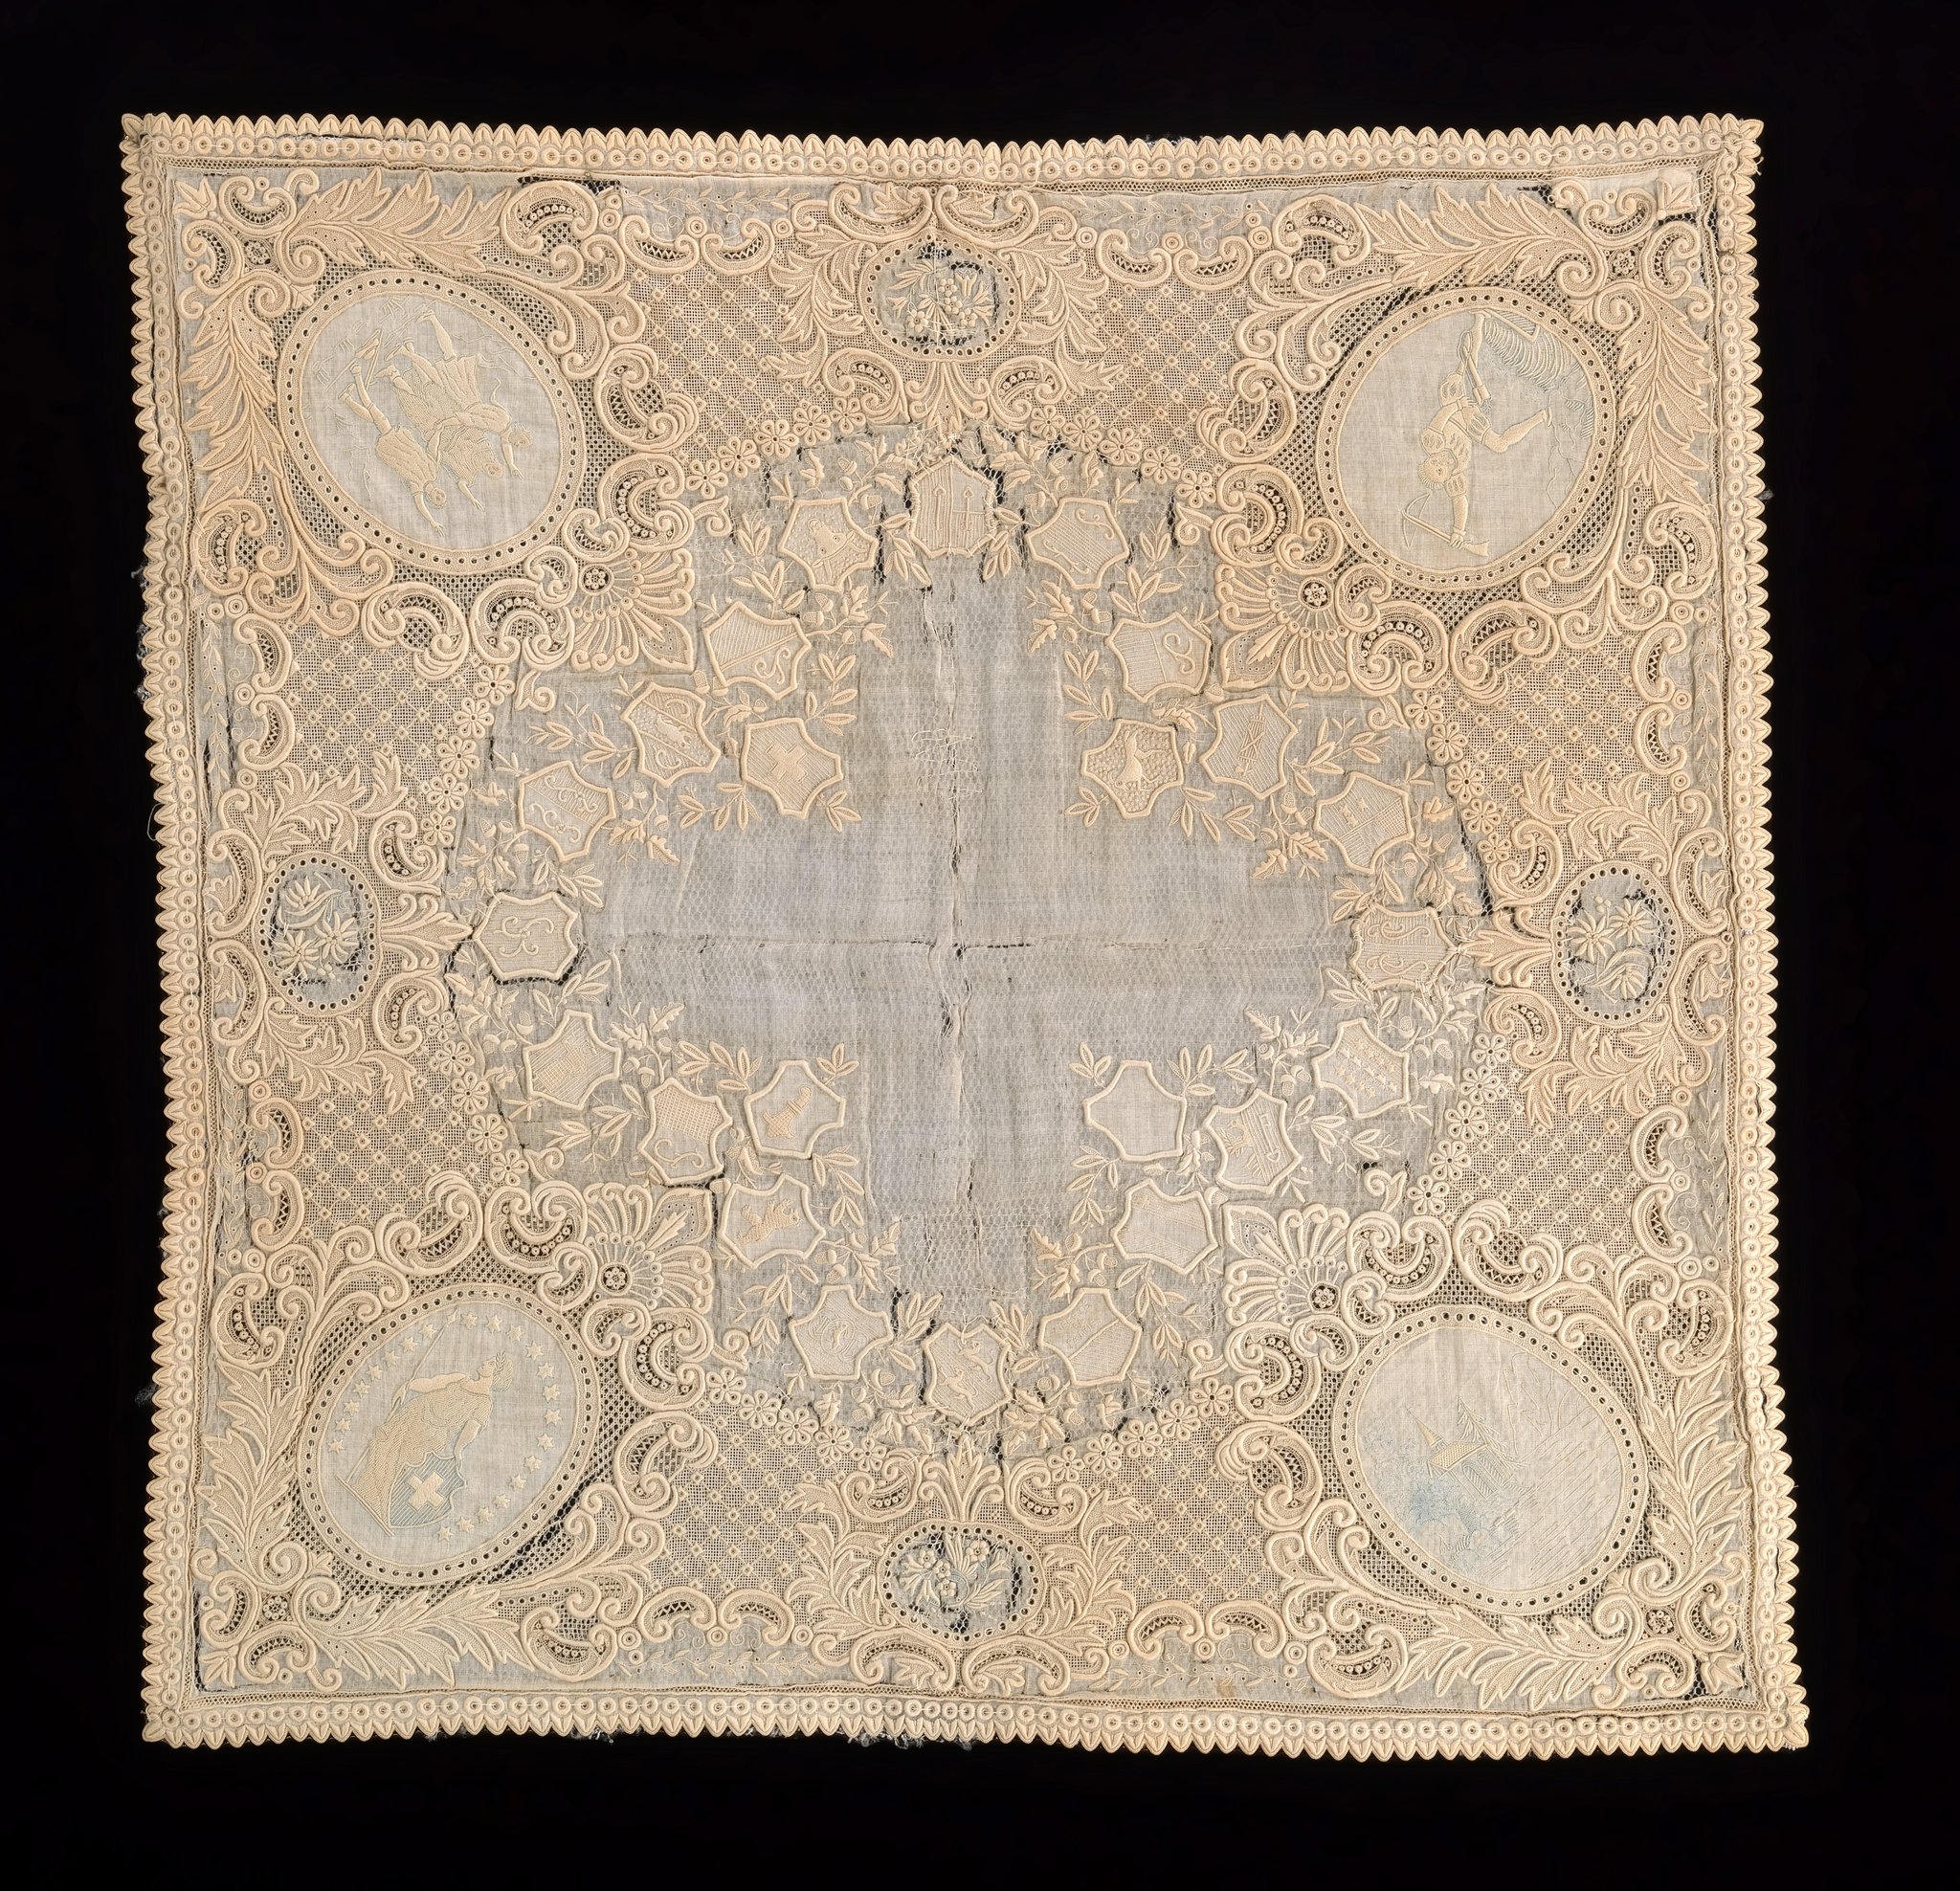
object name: handkerchief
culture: swiss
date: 1851-1875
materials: cotton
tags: churches,men,flowers